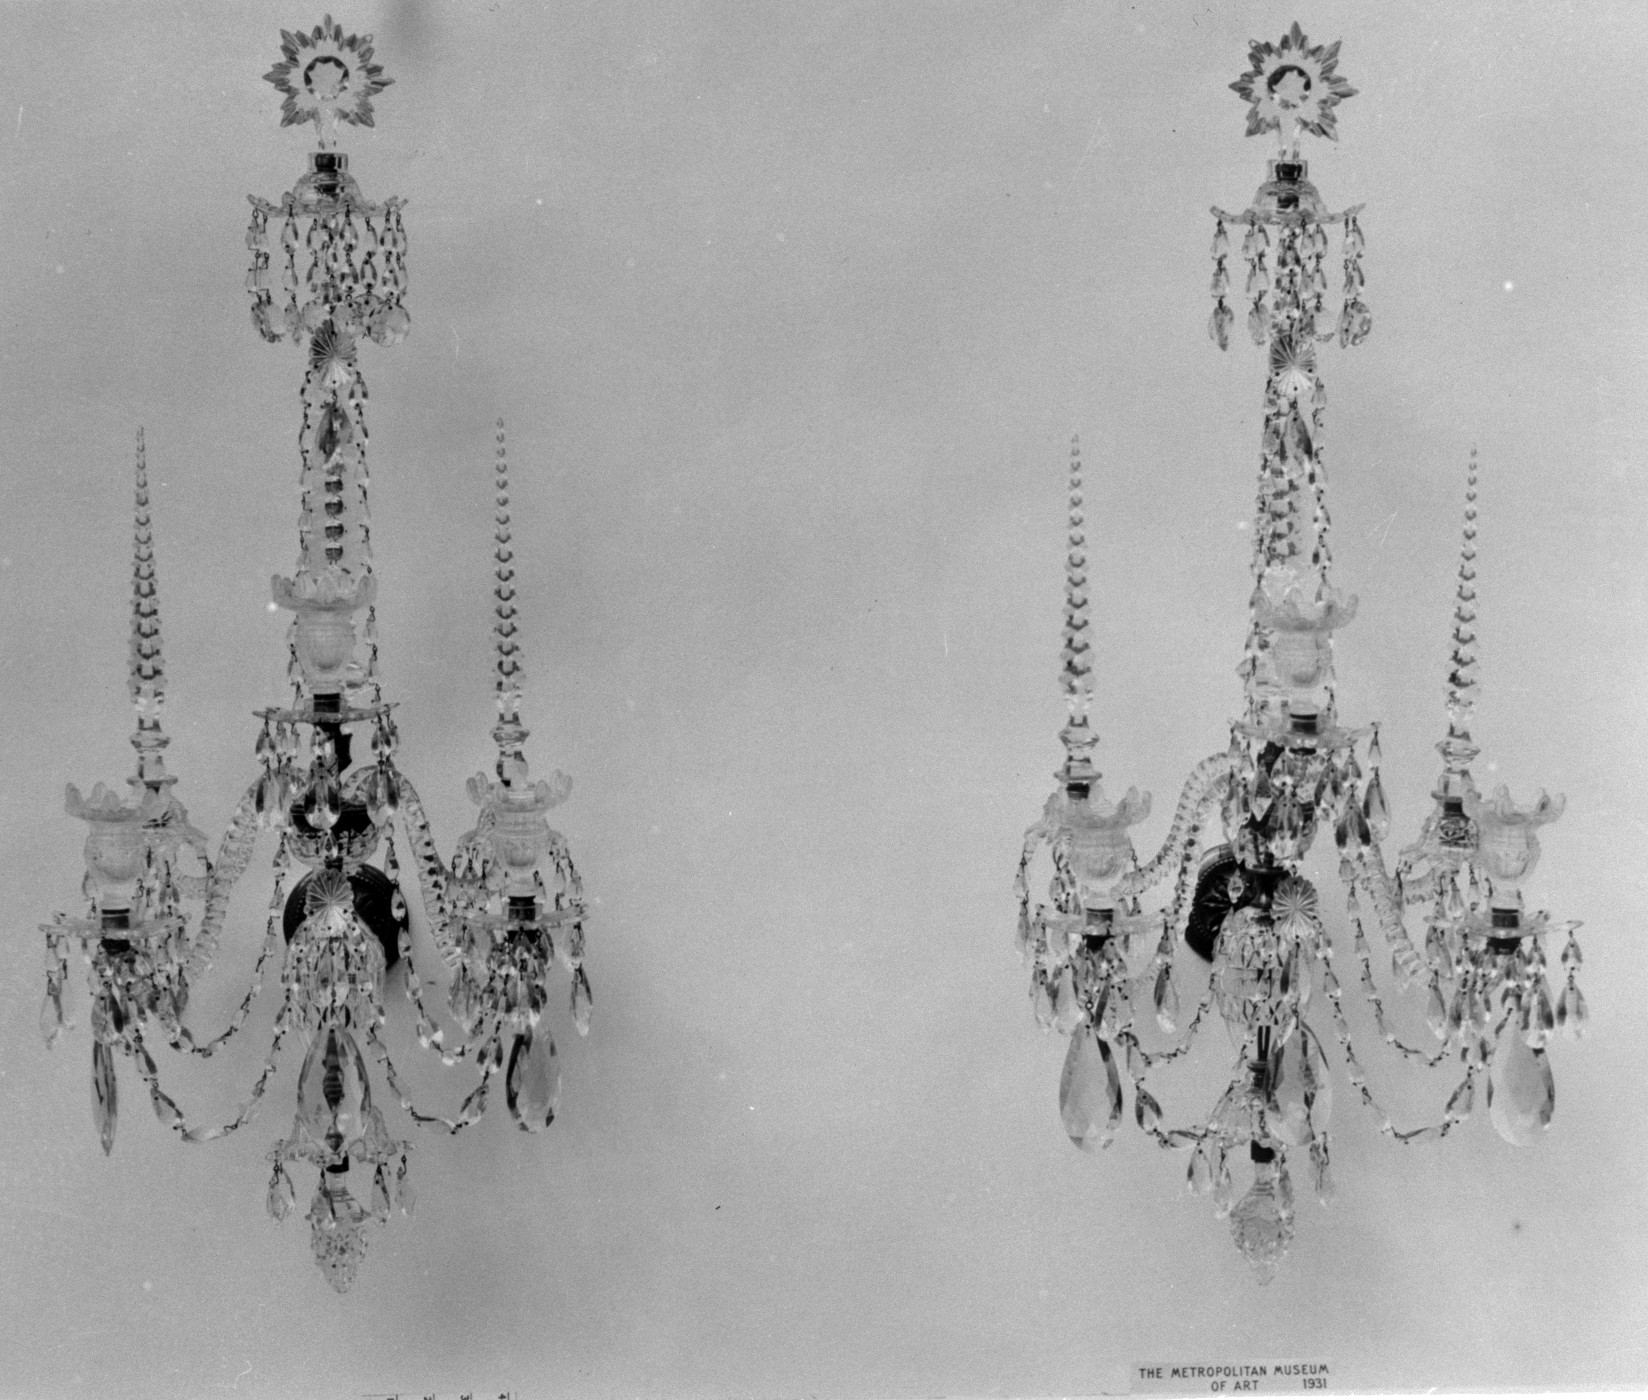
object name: sconce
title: Pair of sconces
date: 1701-1900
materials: gilt bronze, glass